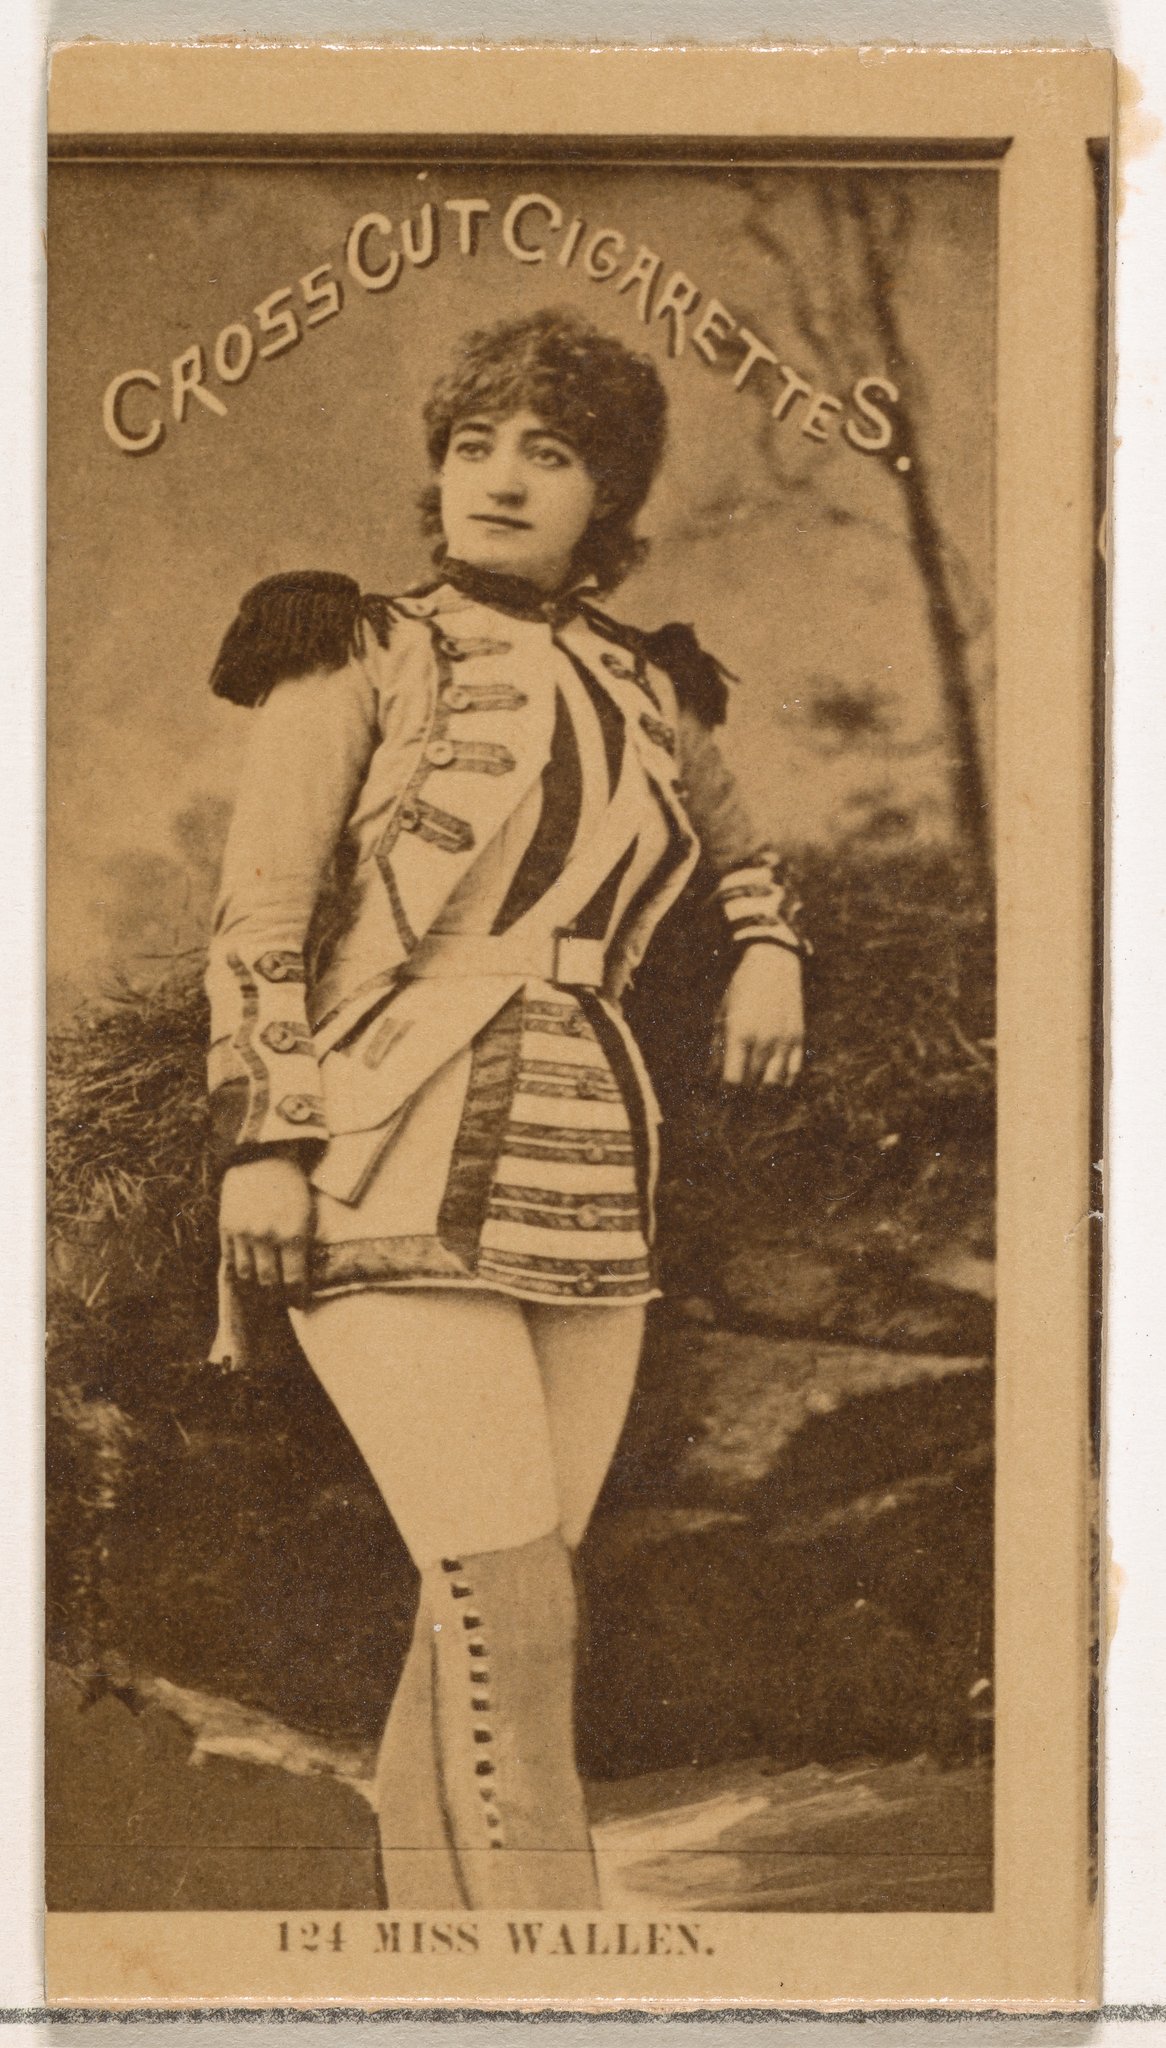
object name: print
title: Card Number 124, Miss Wallen, from the Actors and Actresses series (N145-2) issued by Duke Sons & Co. to promote Cross Cut Cigarettes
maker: w. duke, sons & co.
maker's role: publisher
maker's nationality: american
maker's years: 1870-1920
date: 1880-1889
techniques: albumen silver print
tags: portraits,women,actresses